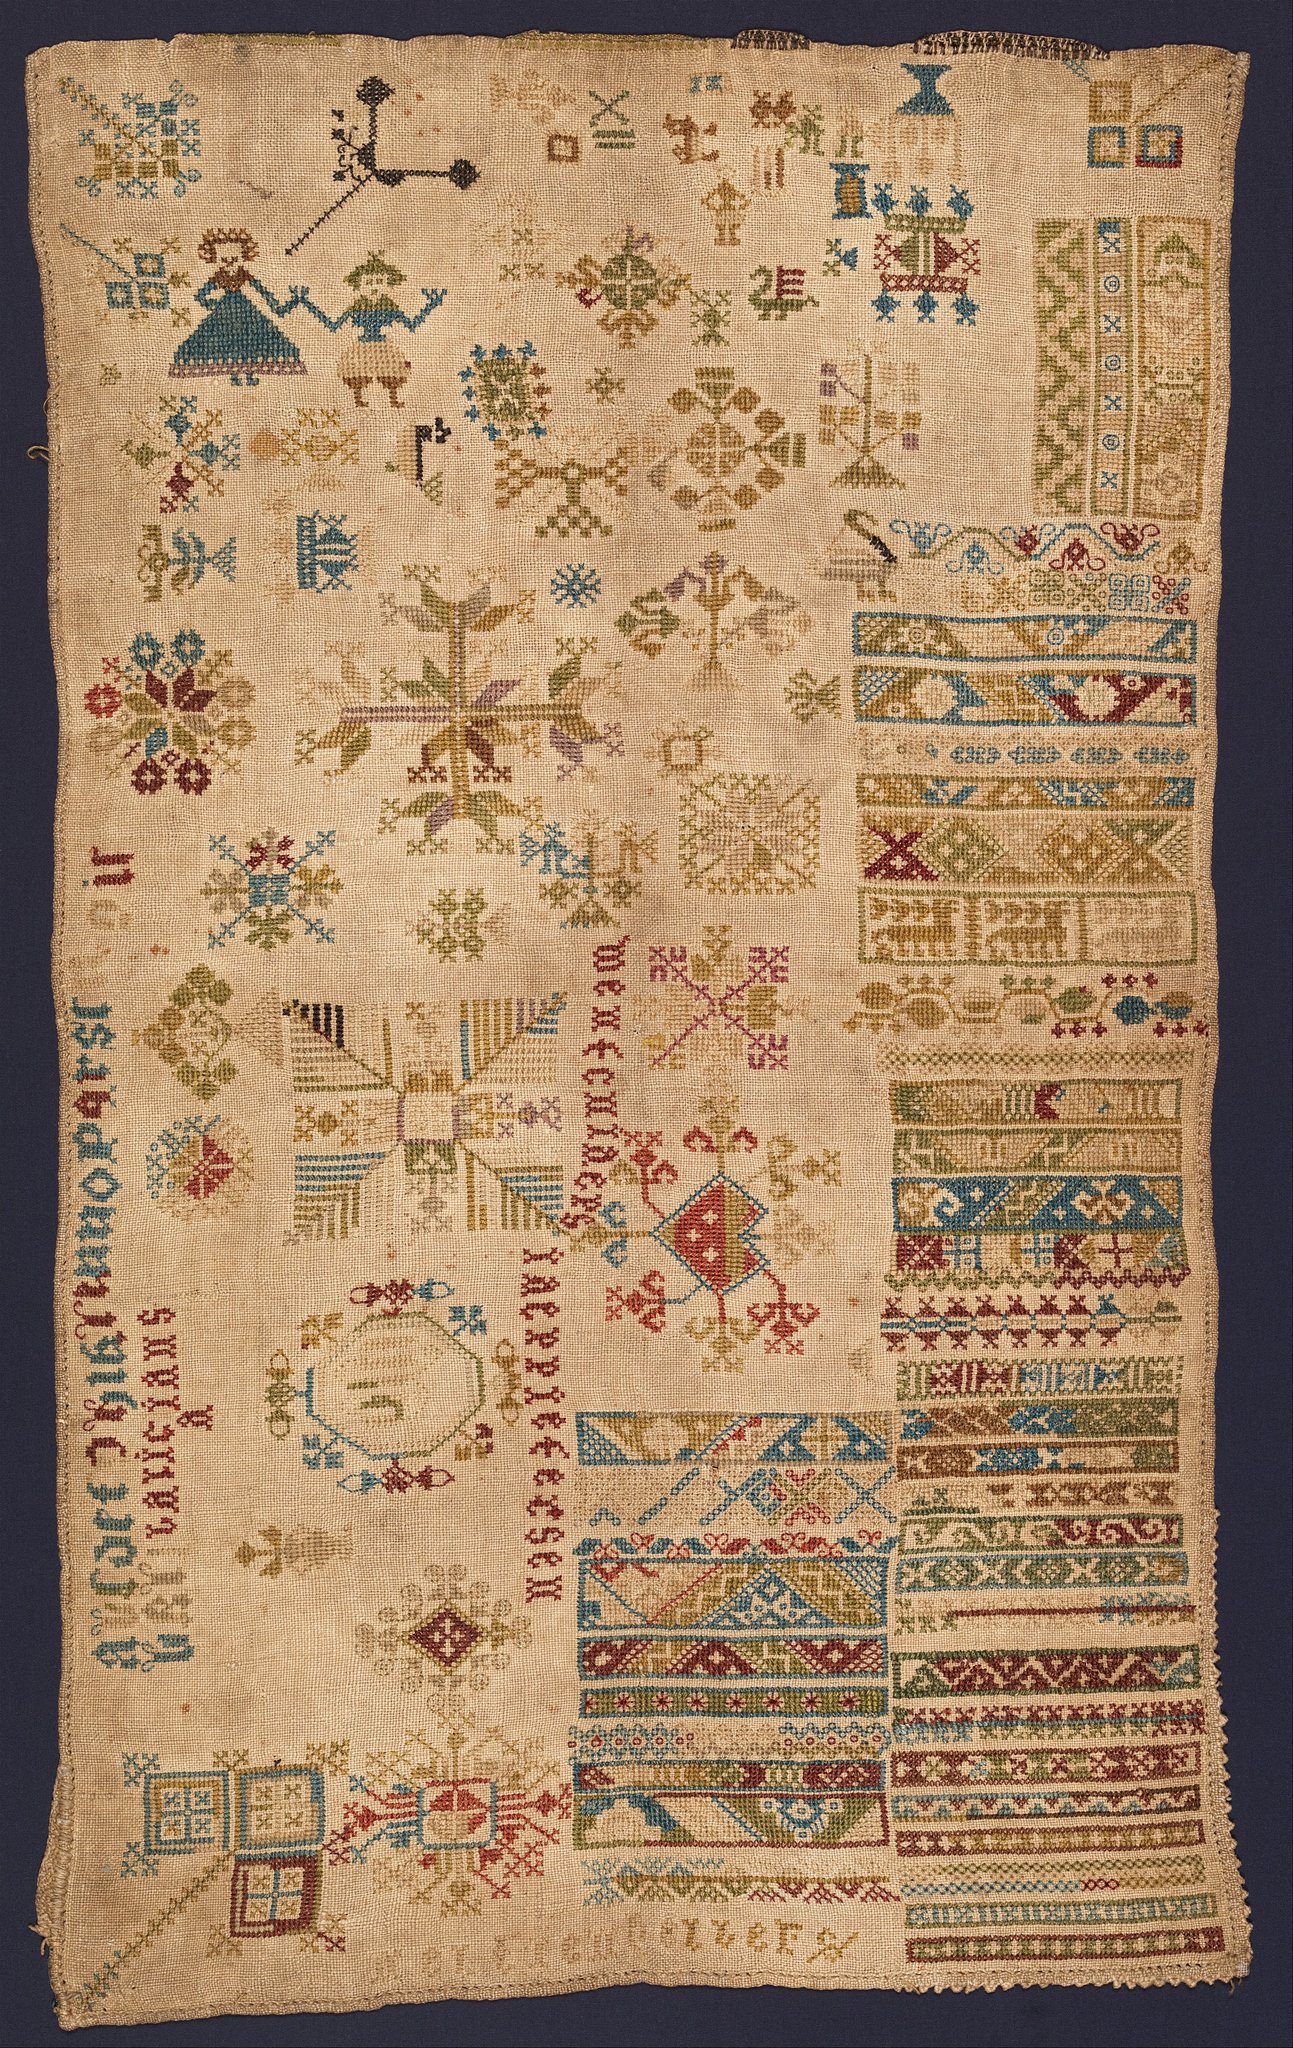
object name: sampler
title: Sampler with geometric patterns, lettering, and various motifs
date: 1634-1666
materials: linen, silk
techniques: embroidery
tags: human figures